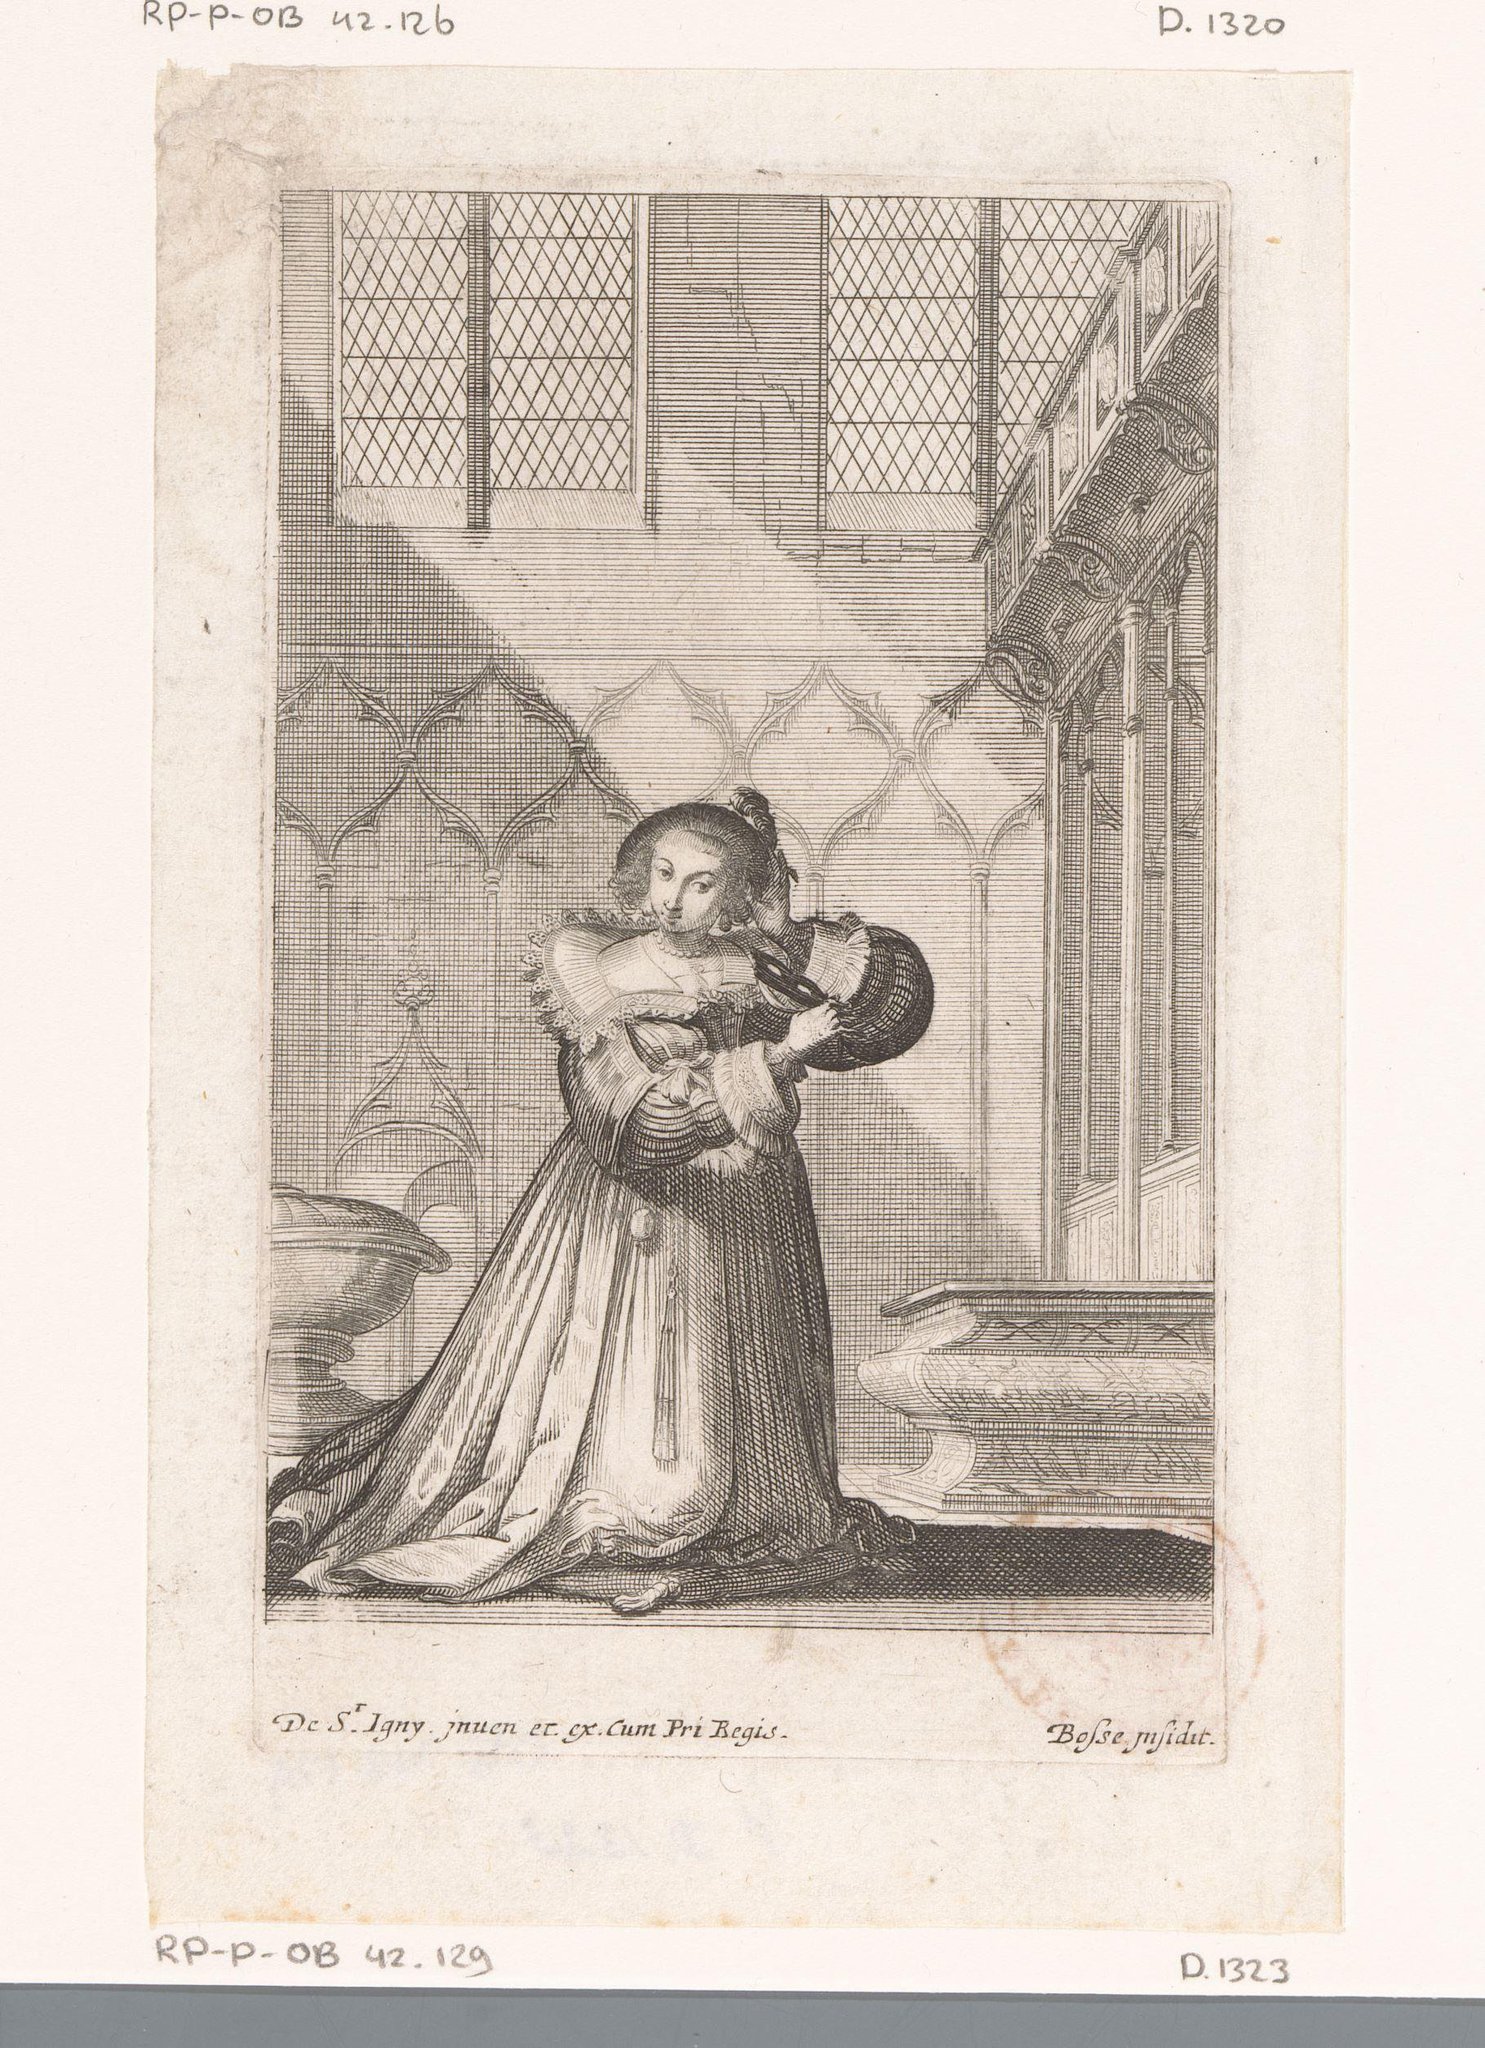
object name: costume print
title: La Noblesse Française à l’église (The French Nobility at Church)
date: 1628-1629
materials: paper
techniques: engraving, etching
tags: black velvet or satin mask, 'loup', 'cachenez' (+ women's clothes), skirt (underskirt) (+ women's clothes), styles of hairdress - aa - ~ women, neck-gear: collar (+ women's clothes), clothes, costume (+ women's clothes), skirt (+ women's clothes), sleeves: cuffs (+ women's clothes), dress, gown (+ women's clothes), interior of church, fan (+ women's clothes), sleeves (+ women's clothes), necklace (+ women's clothes), clothing for the upper part of the body (with name) (+ women's clothes)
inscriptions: collector's mark: Lugt 240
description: Bosse portrayed the Gothic churches of Paris as sites of piety and fashionability. While praying or merely strutting through the centuries-old architecture, the churchgoers in these prints sport the latest styles. For example, in the few years since Callot’s series (adjacent), an ornate and expensive form of lace cutwork – reticella – had become a popular form of decoration for collars and cuffs.